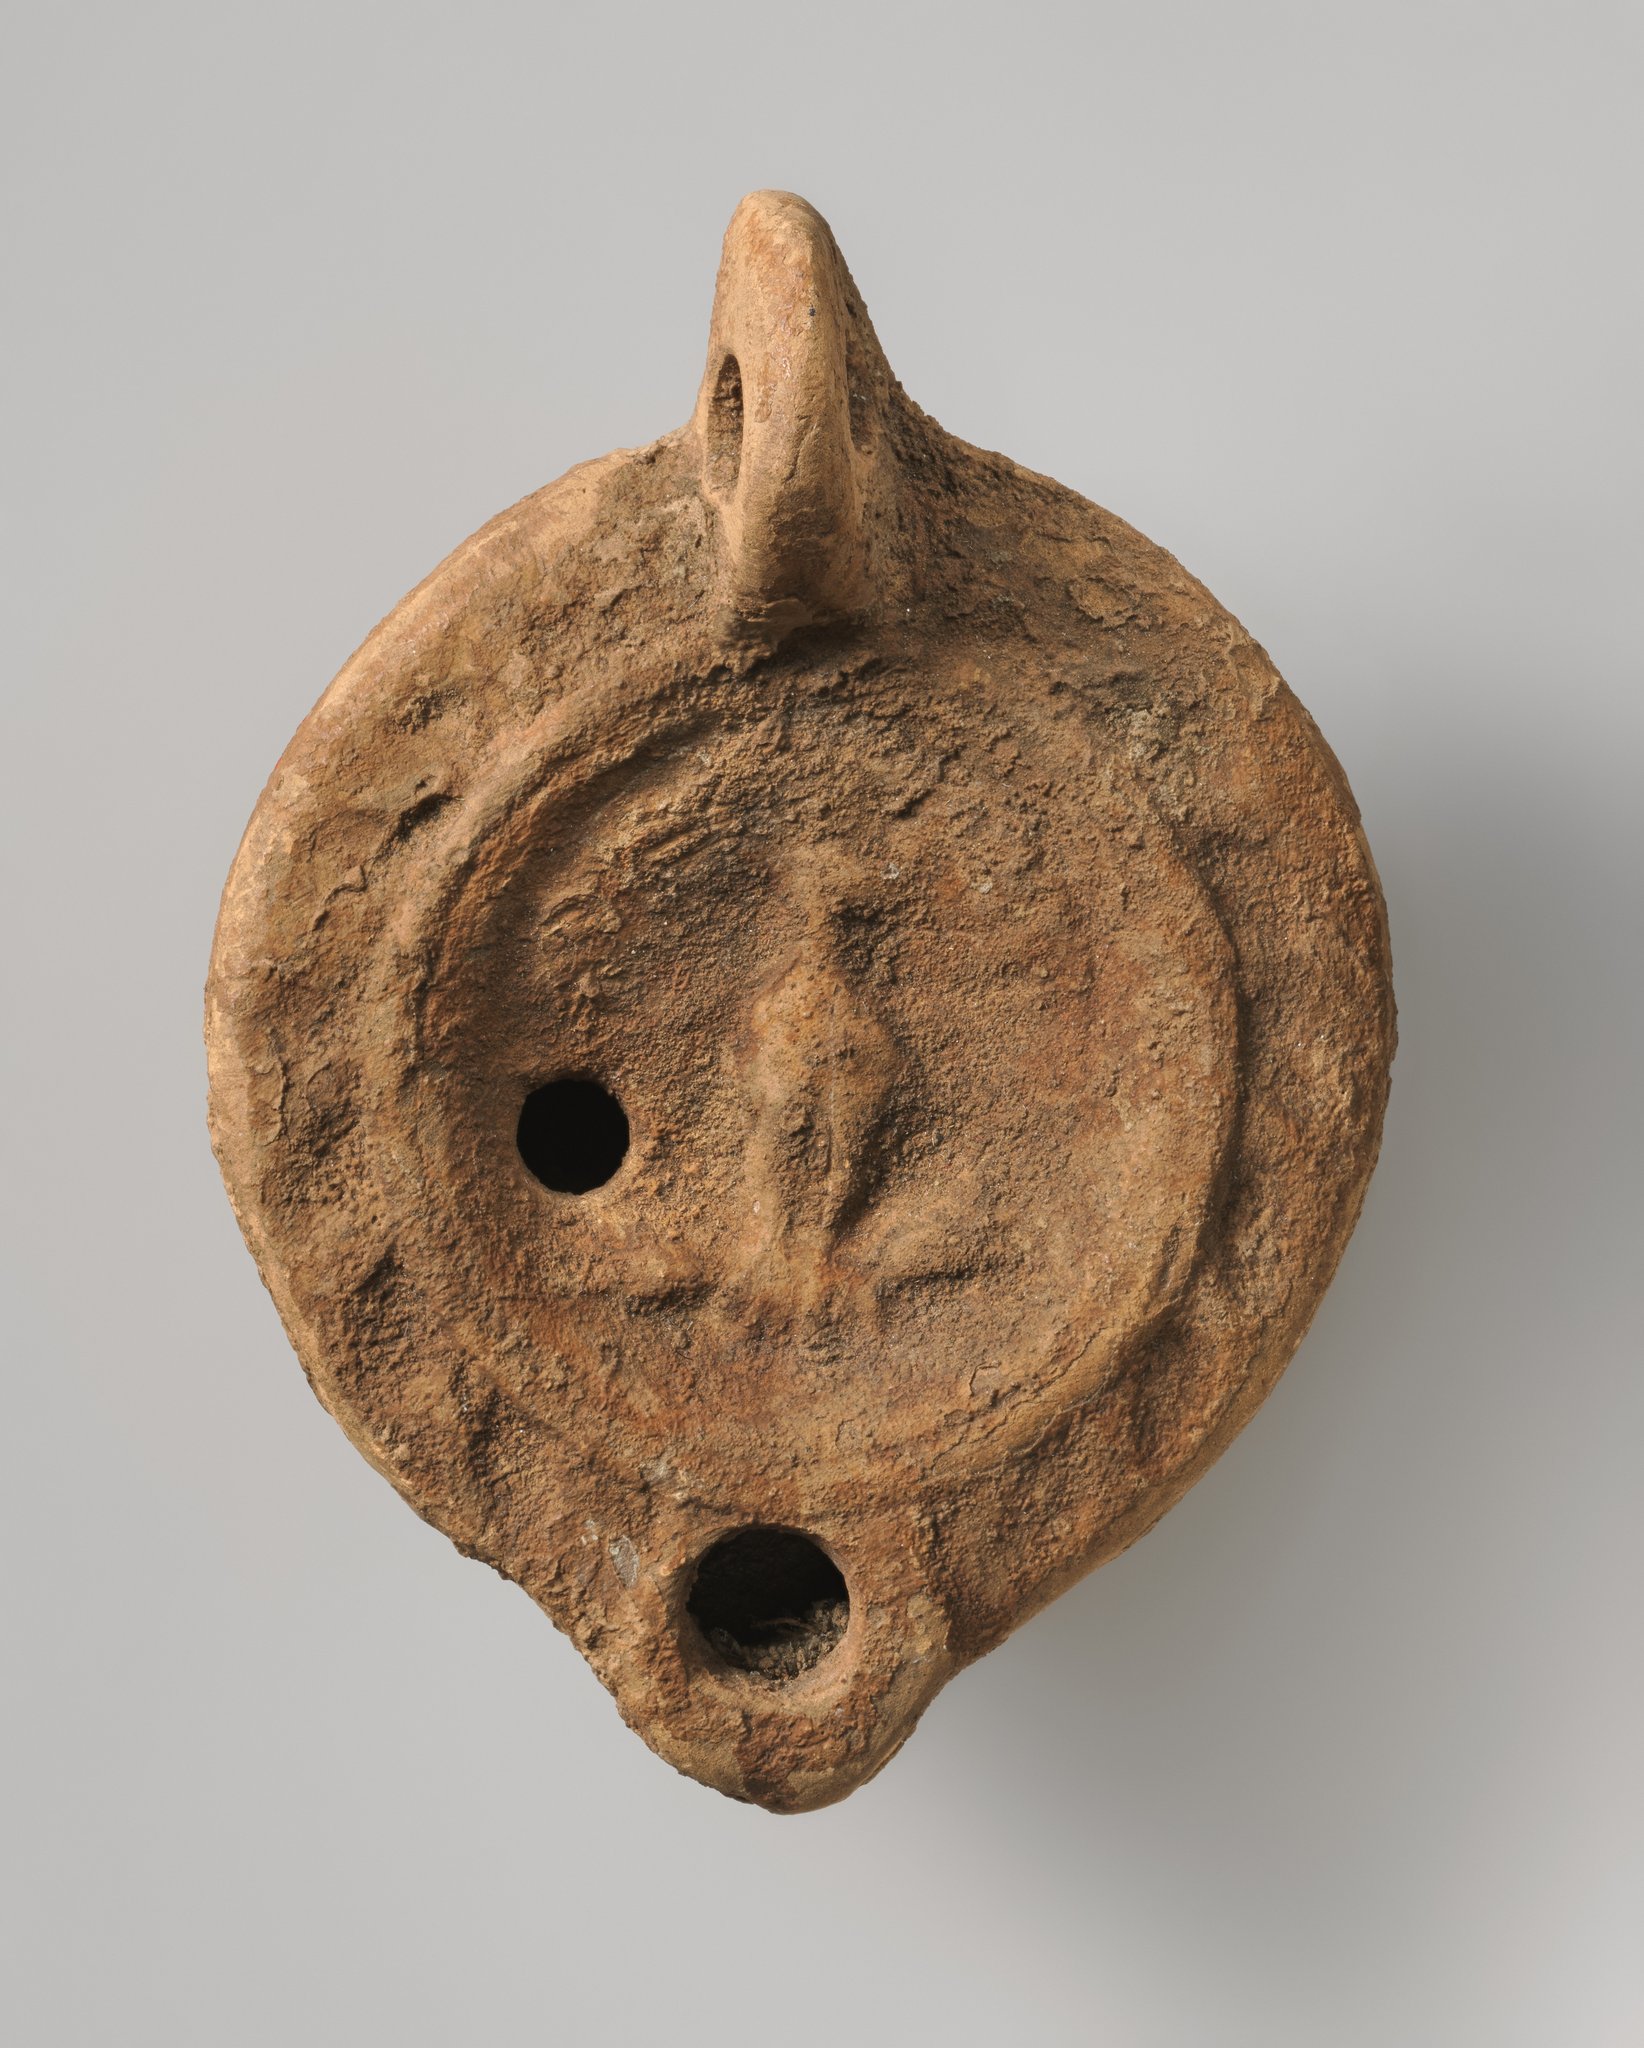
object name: lamp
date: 201-1200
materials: earthenware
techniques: molding